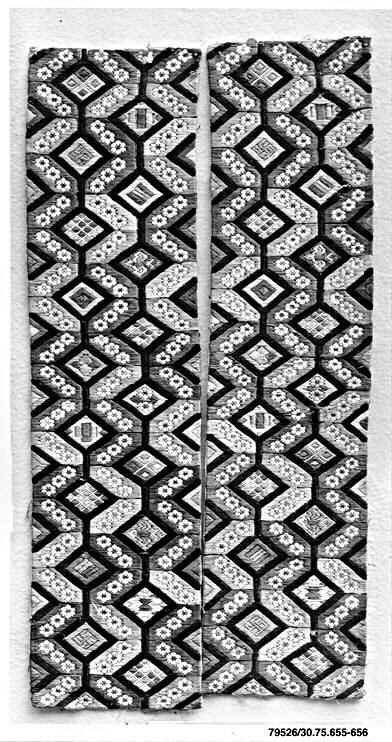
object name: piece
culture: chinese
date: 1644-1911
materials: silk